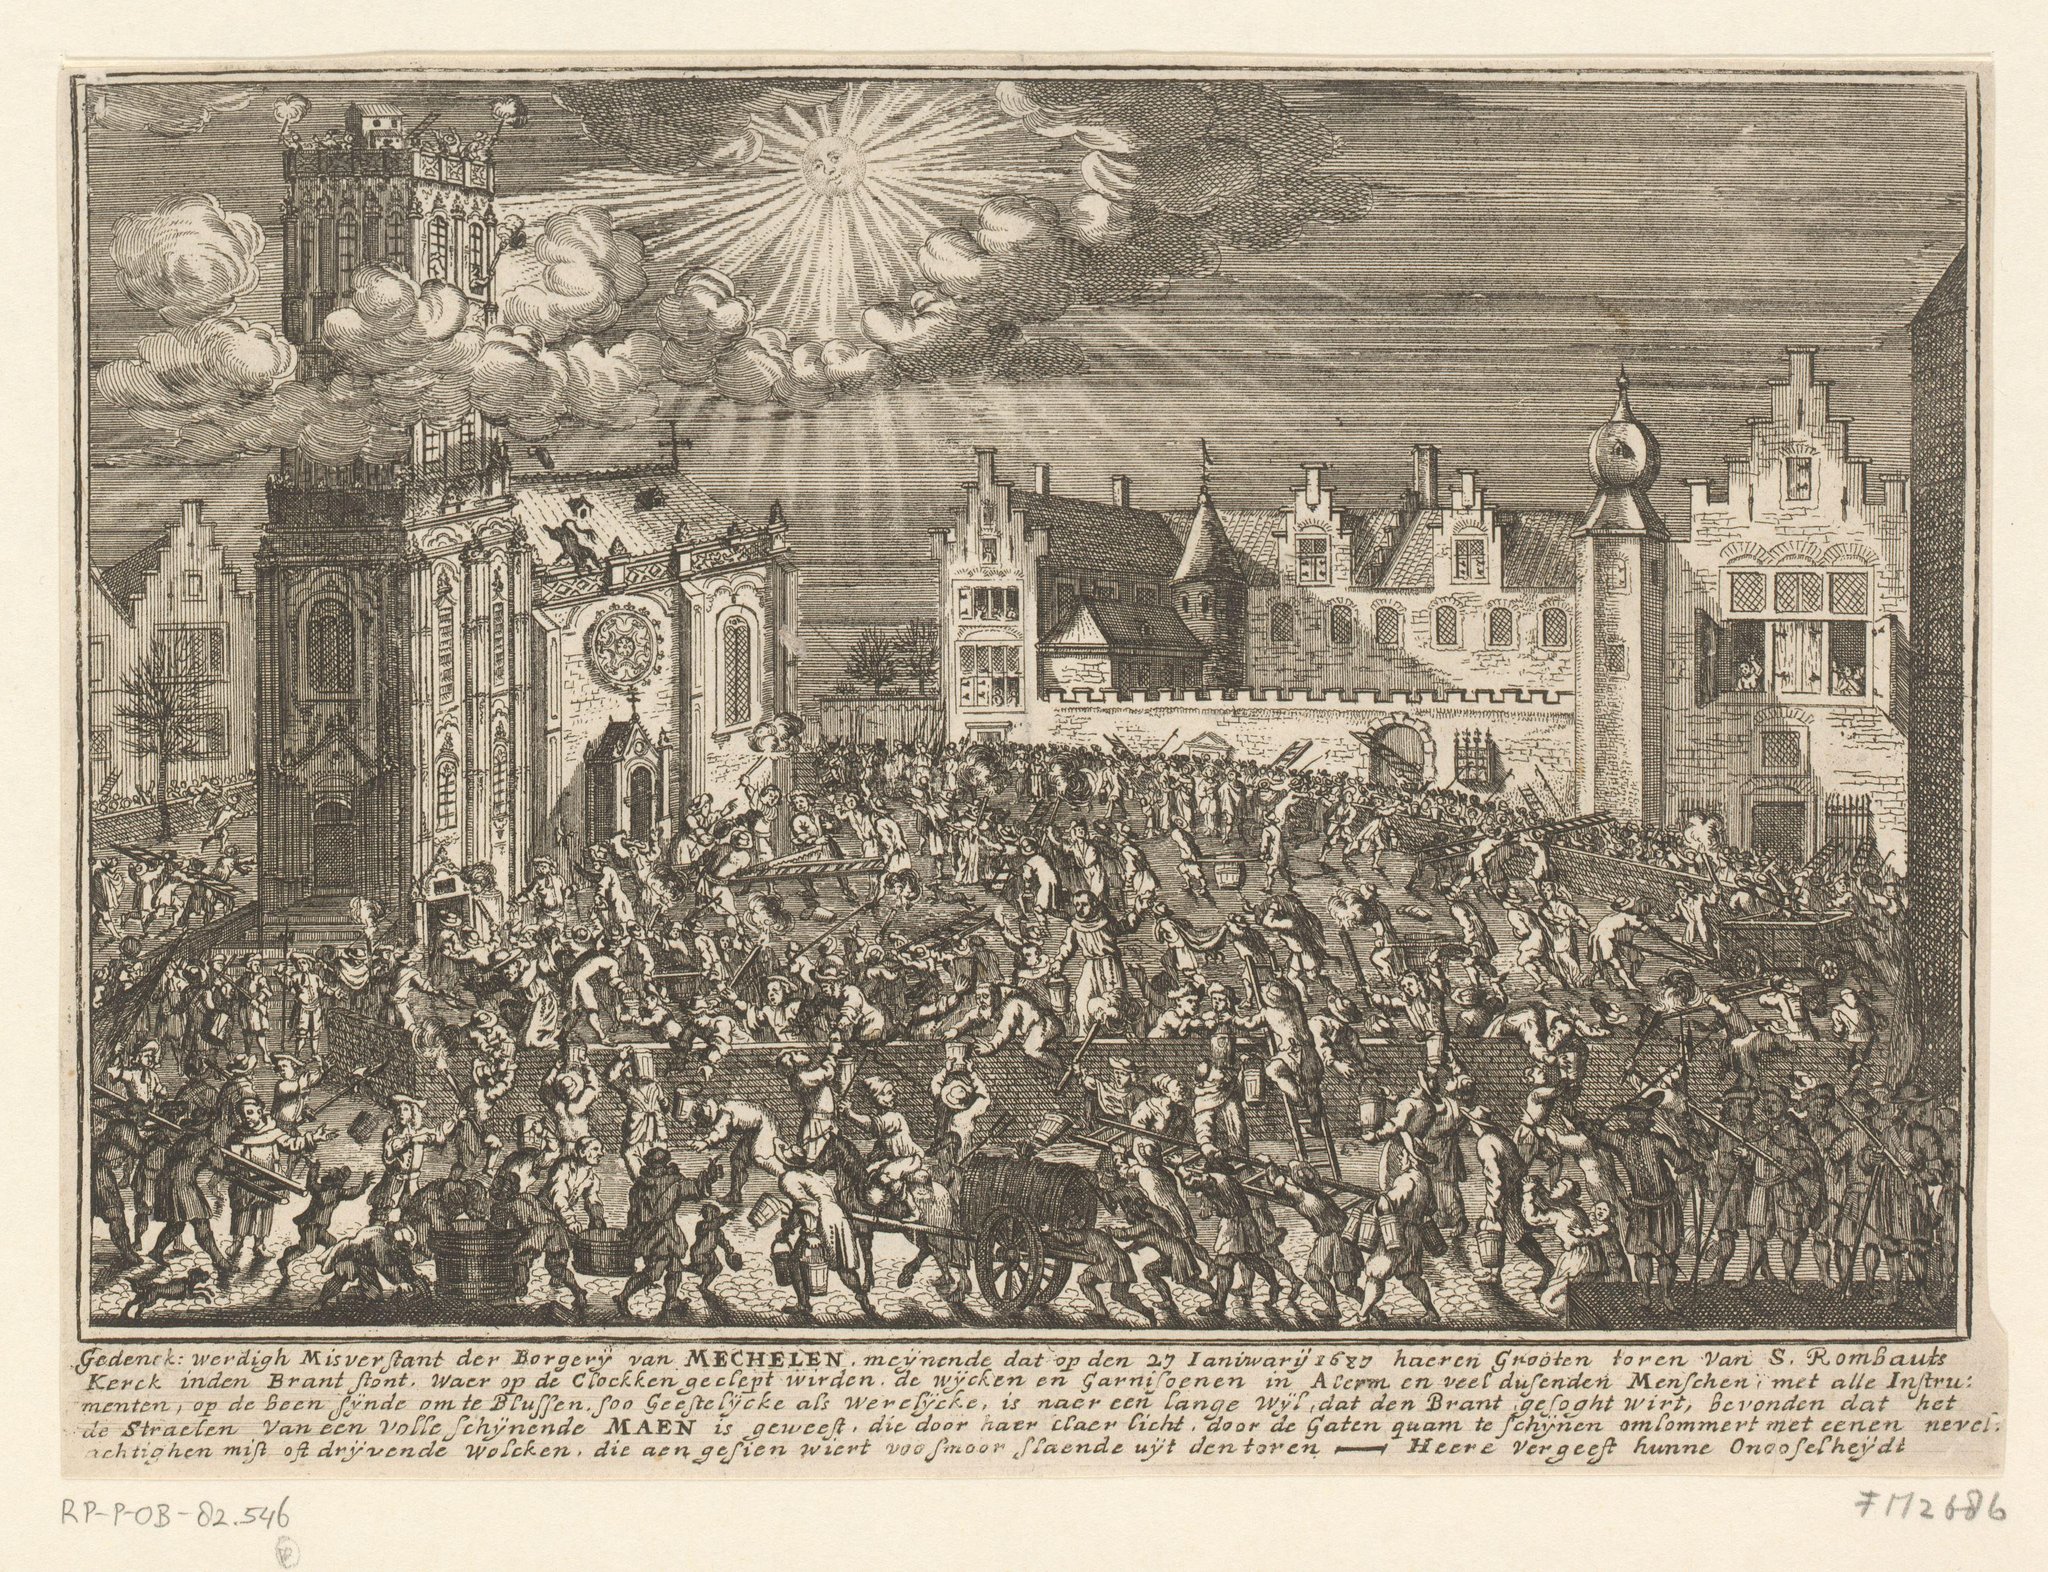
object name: print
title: Gedenck-werdigh Misverstant der Borgery van Mechelen, meynende dat op den 27 Janiwarij 1687 haeren Grooten toren van S. Rombauts Kerck in den Brant stont (...)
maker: Anonymous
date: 1687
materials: paper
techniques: etching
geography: southern netherlands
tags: fire-fighting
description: Mechelse maanbrand. Spotprent op de inwoners van Mechelen die ten onrechte menen dat de toren van de Sint-Rombaut in brand staat, 27 januari 1687. Het blijkt echter slechts het licht van de volle maan tussen nevelen te zijn. Nachtvoorstelling met de toegestroomde menigte gewapend met ladders en blusmiddelen op het kerksplein. Met onderschrift van 5 regels eindigend met de woorden: Heere vergeeft hunne Onooselheydt.